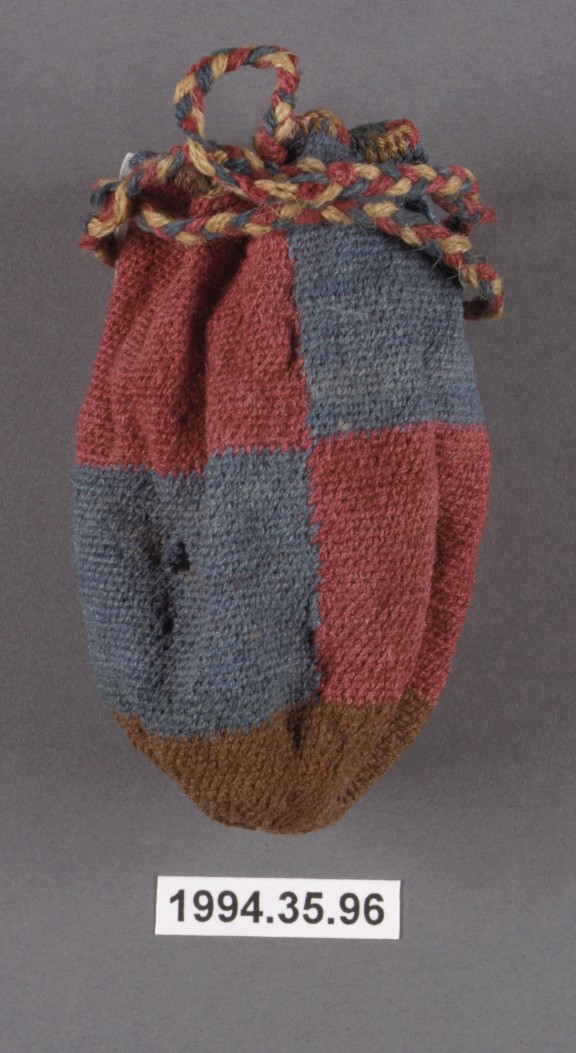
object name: bag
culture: nasca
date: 101-700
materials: animal fiber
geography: peru